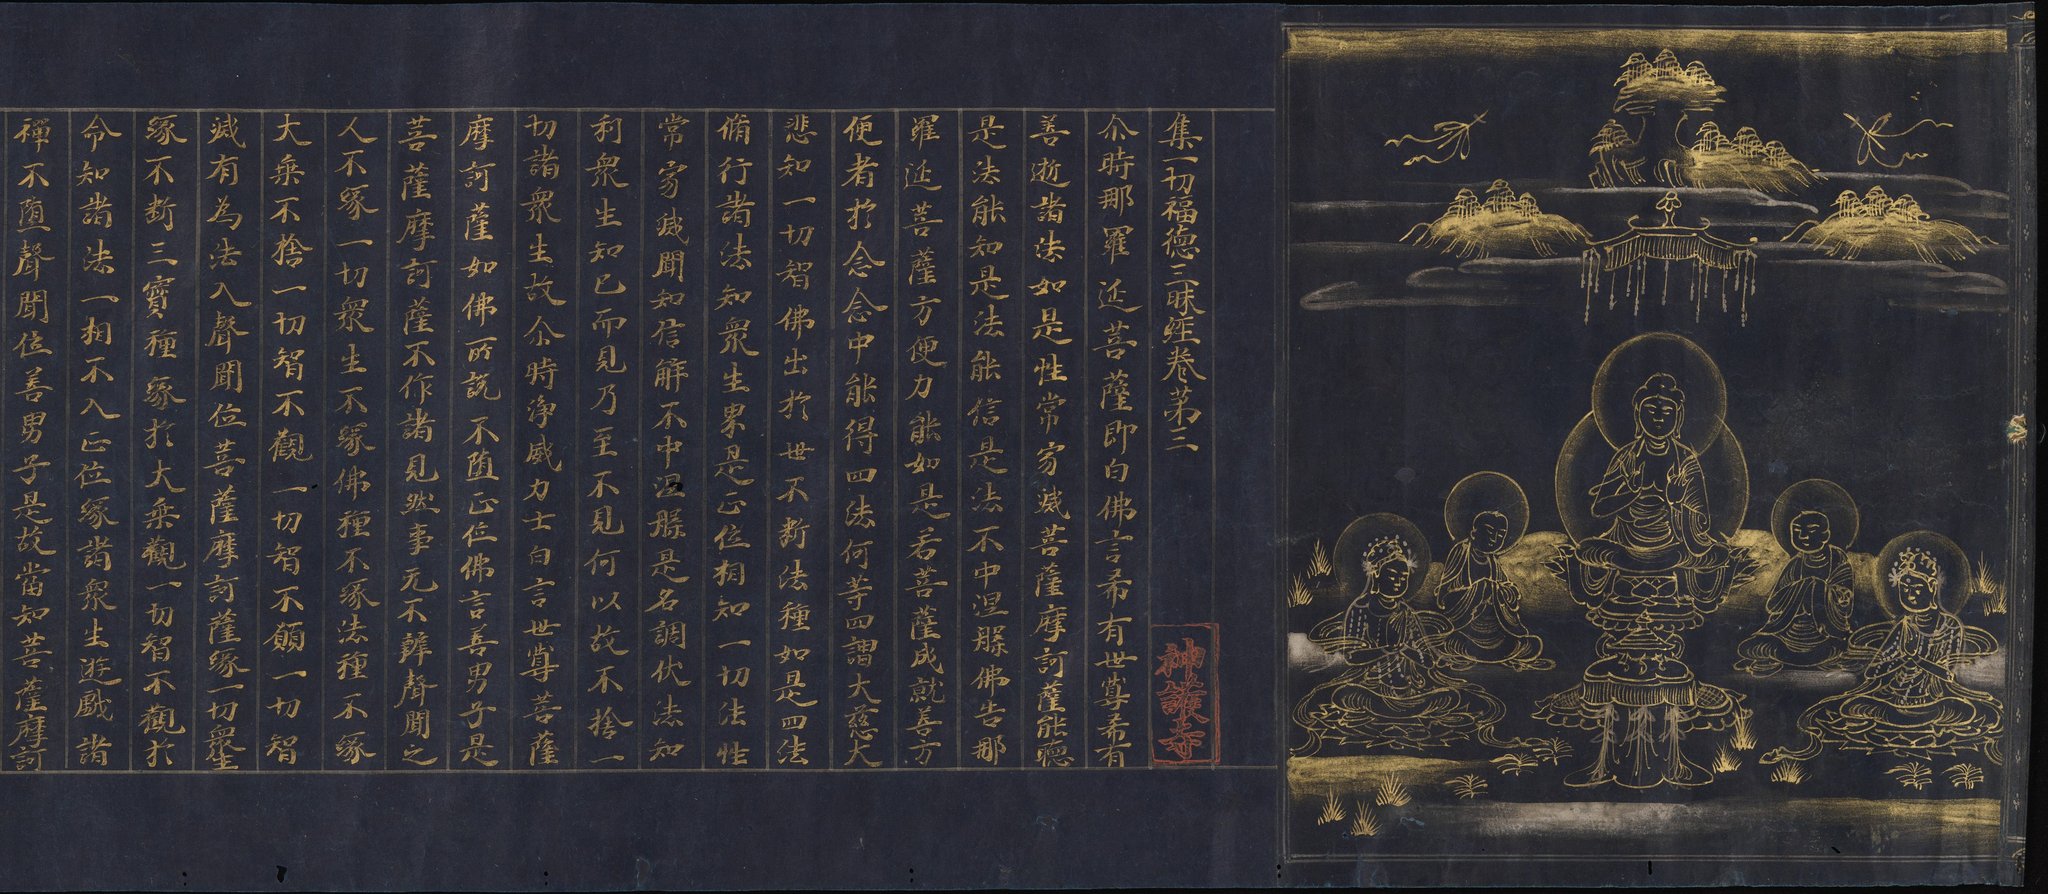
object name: handscroll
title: Illustrated Frontispiece to the Sutra of Enlightenment through the Accumulation of Merit and Virtue, the So-called Jingoji Sutra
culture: japanese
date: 1150-1185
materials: gold, paper, silver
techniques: dyeing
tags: buddhism,bodhisattvas,buddha